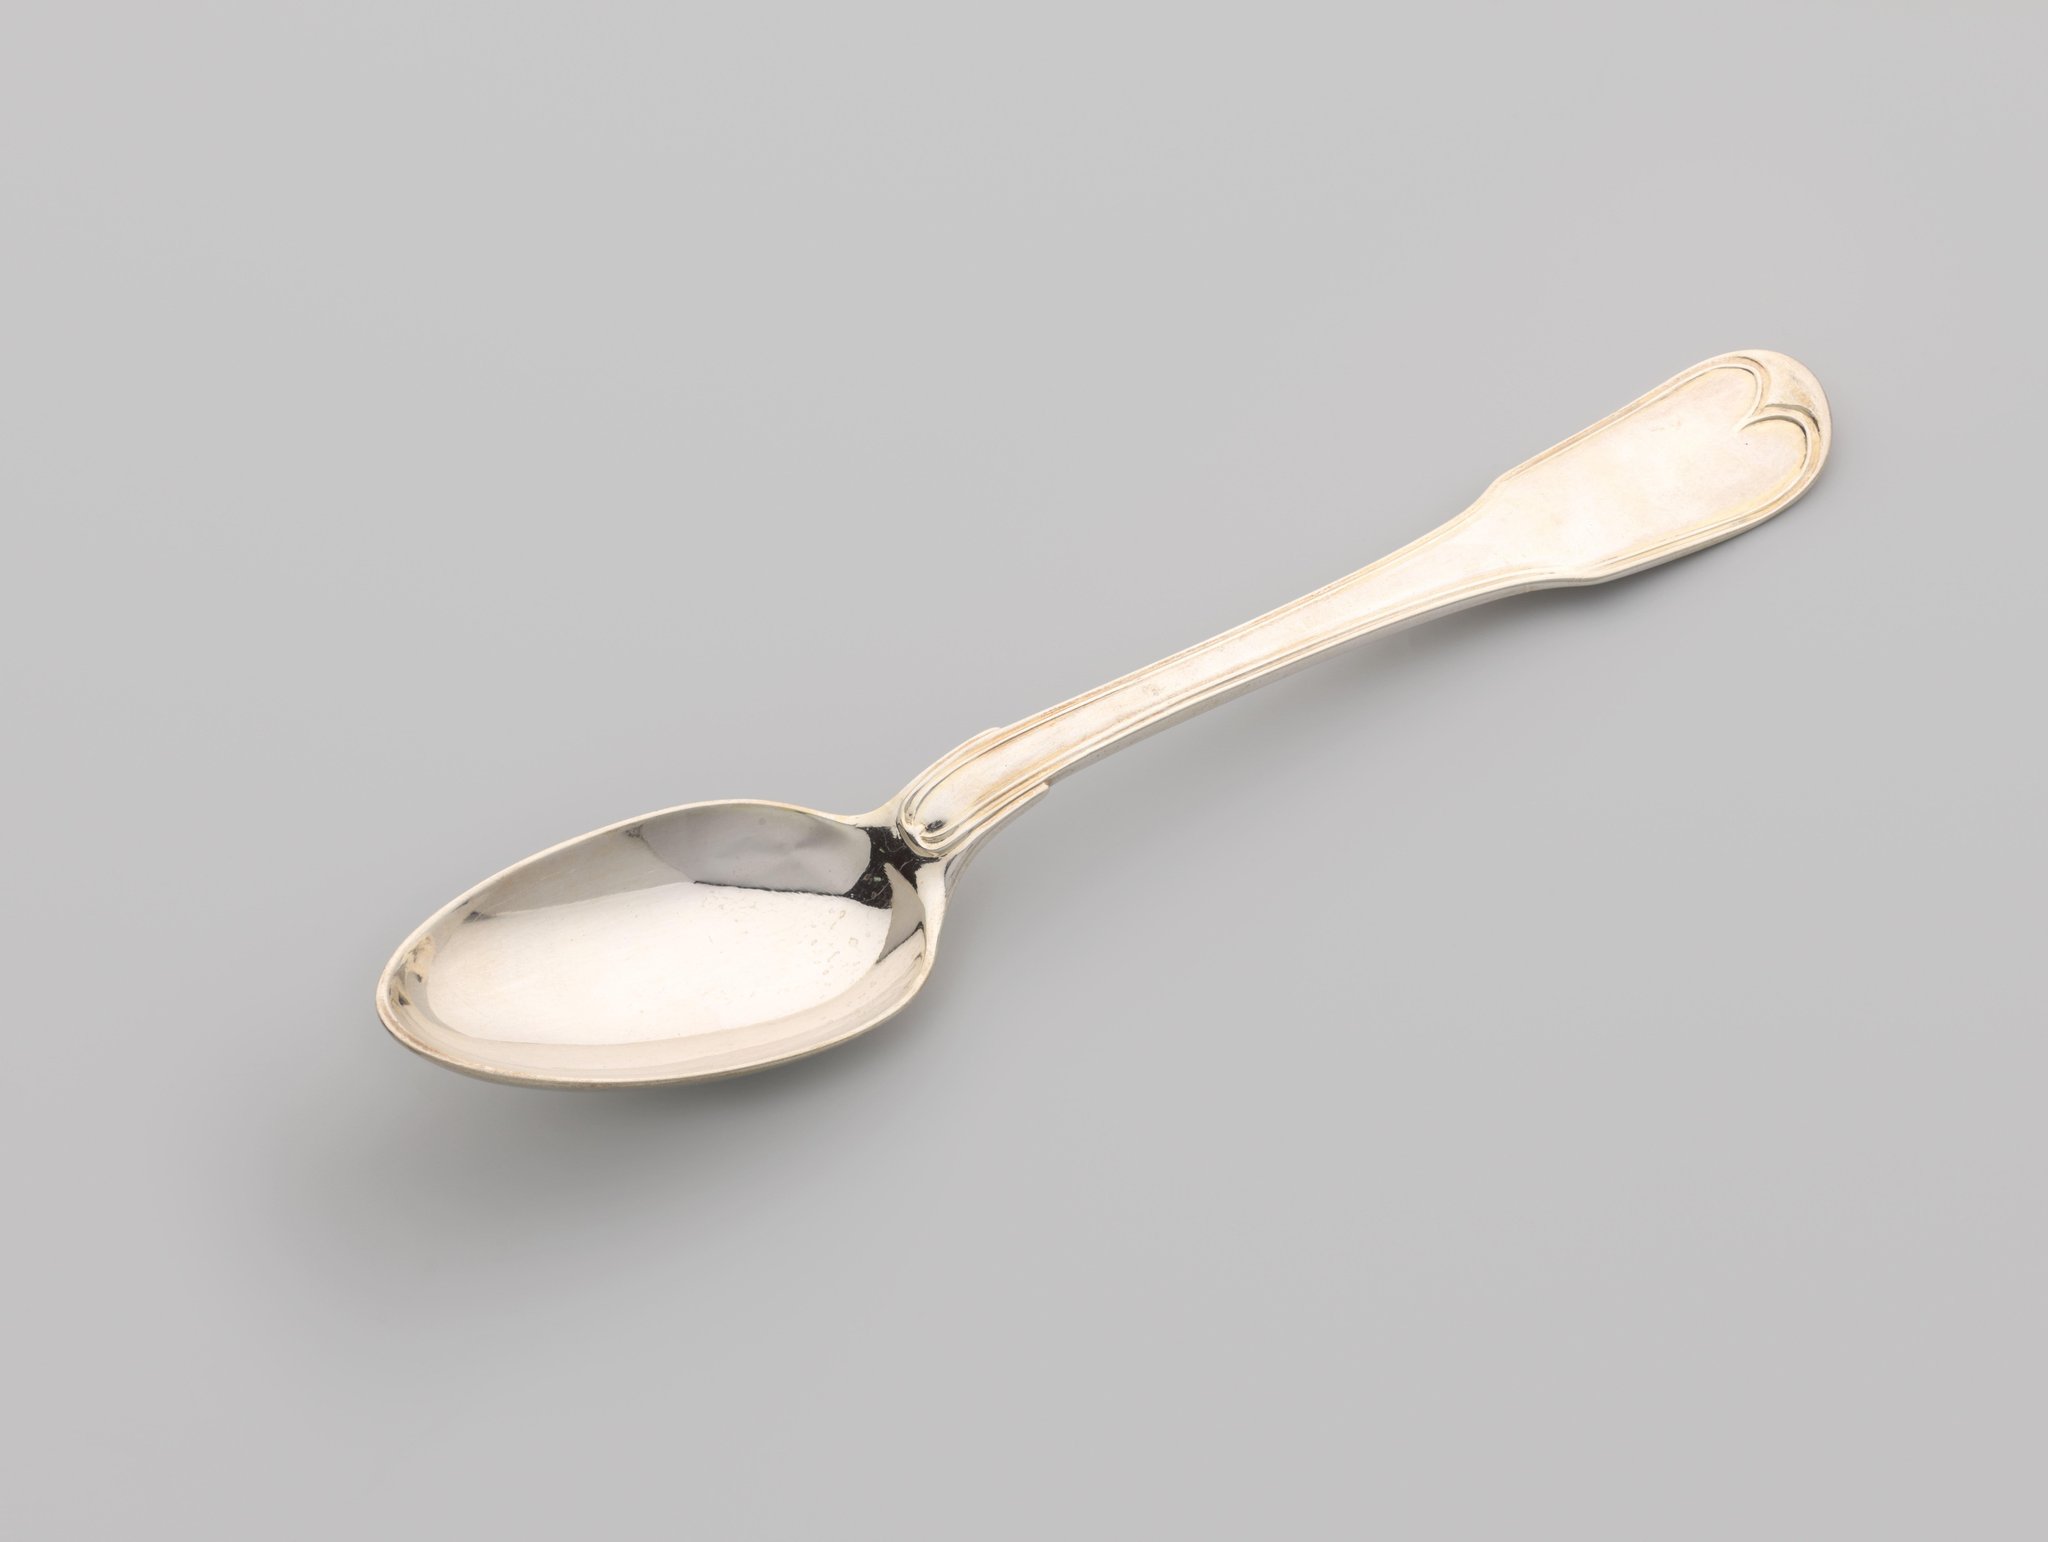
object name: spoon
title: Dessertlepel met het helmteken Clifford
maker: roelof helweg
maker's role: silversmith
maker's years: 1758-1843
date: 1806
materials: silver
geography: amsterdam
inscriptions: alloy mark: ‘Hollandse leeuw’, town mark: ‘Amsterdam’, date letter: ‘X (=1806)’, maker's mark: ‘RH in ovaal’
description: De eivormige bak van de lepel heeft een versmald uiteinde en is aan zowel boven- als onderzijde door middel van enkel lof verbonden met de platte, gebogen steel, die zich verbreedt naar het spatelvormige uiteinde. Boven- en onderzijde van de steel worden omgeven door een dubbele filetrand, die bij het uiteinde ingezwenkt is. Op de onderzijde van de spatel van zowel de lepels als de vorken is het helmteken Clifford gegraveerd.